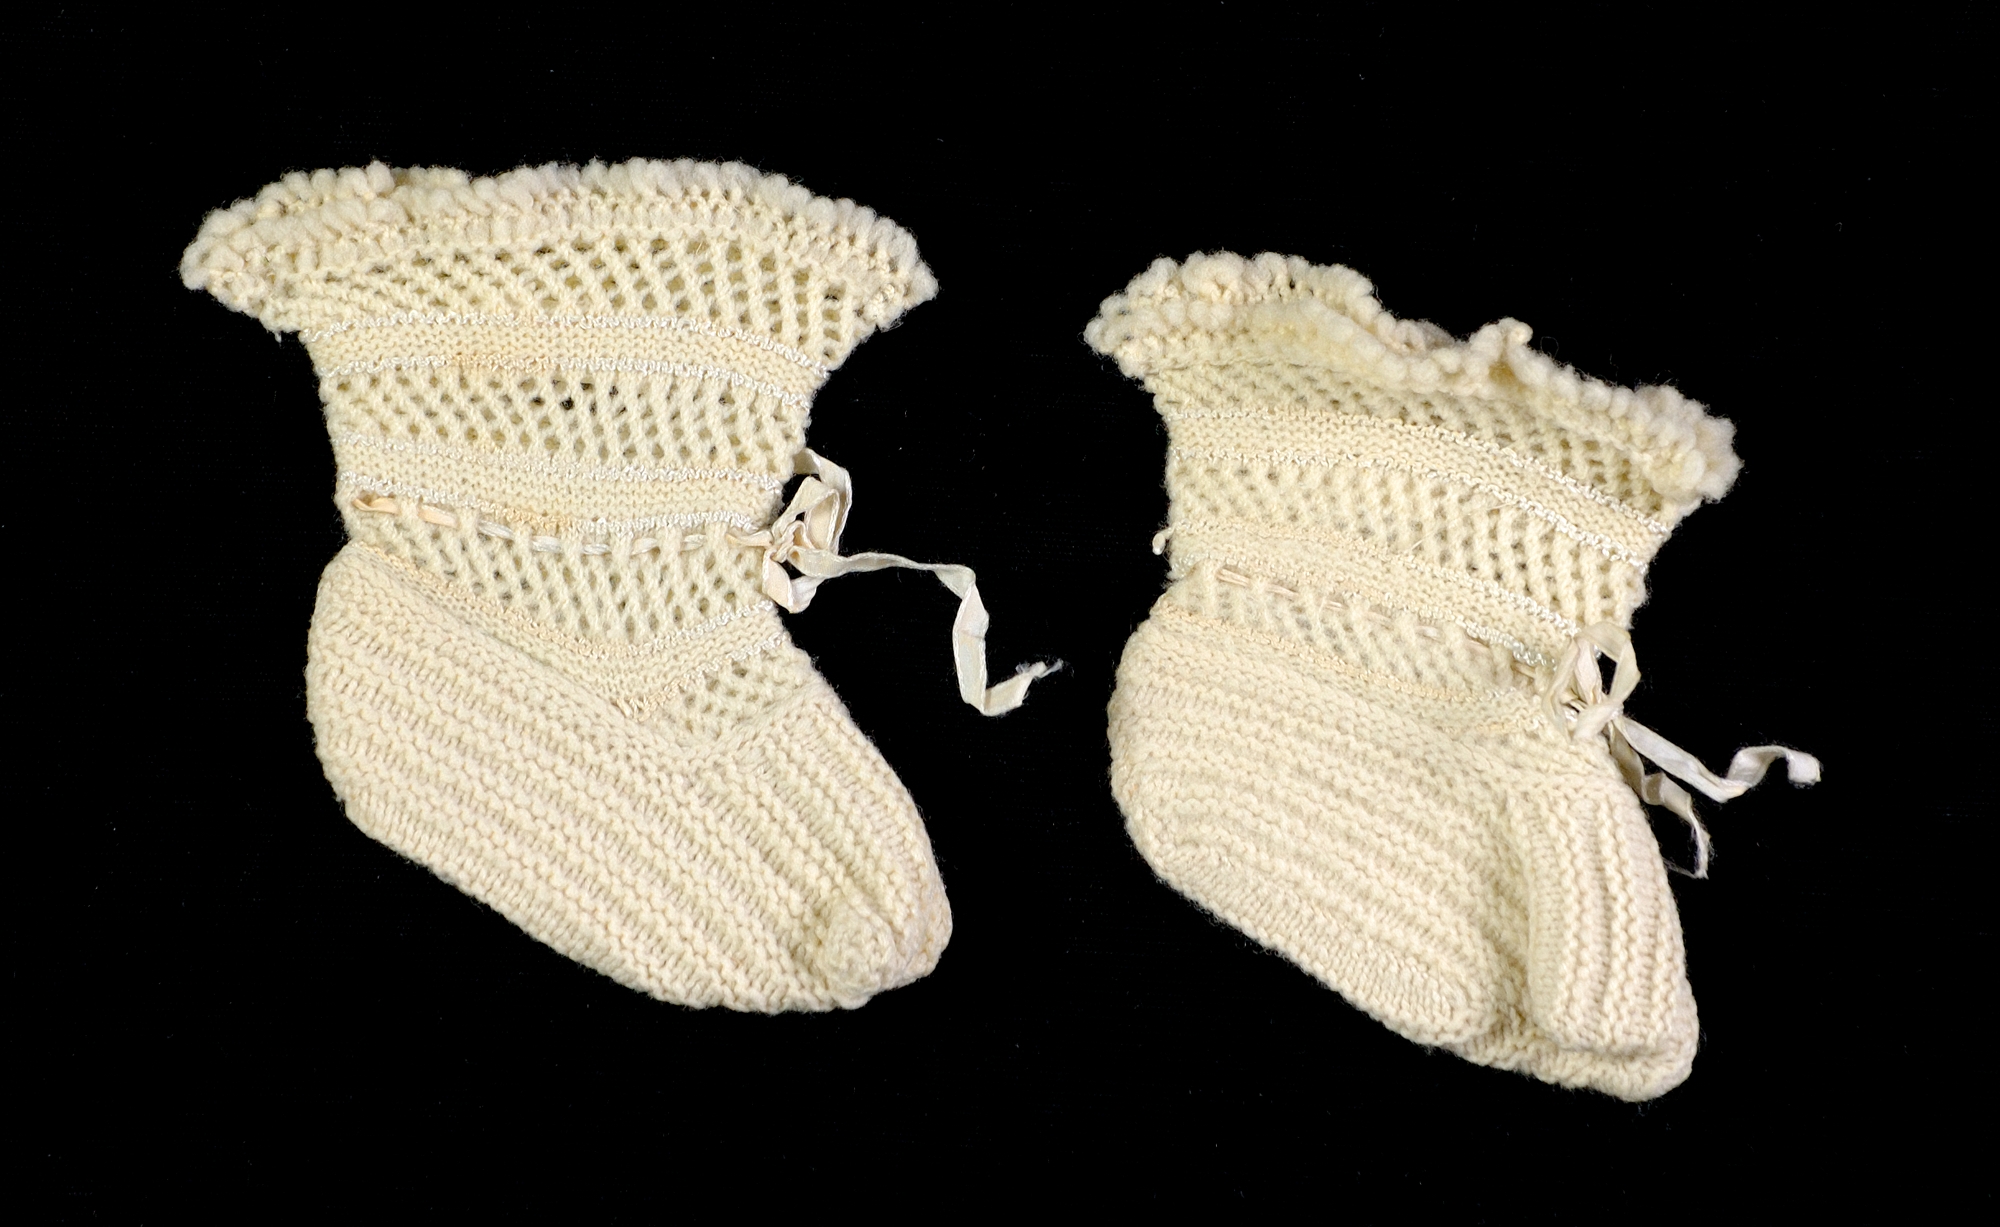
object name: bootee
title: Bootees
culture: american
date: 1840-1860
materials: silk, wool